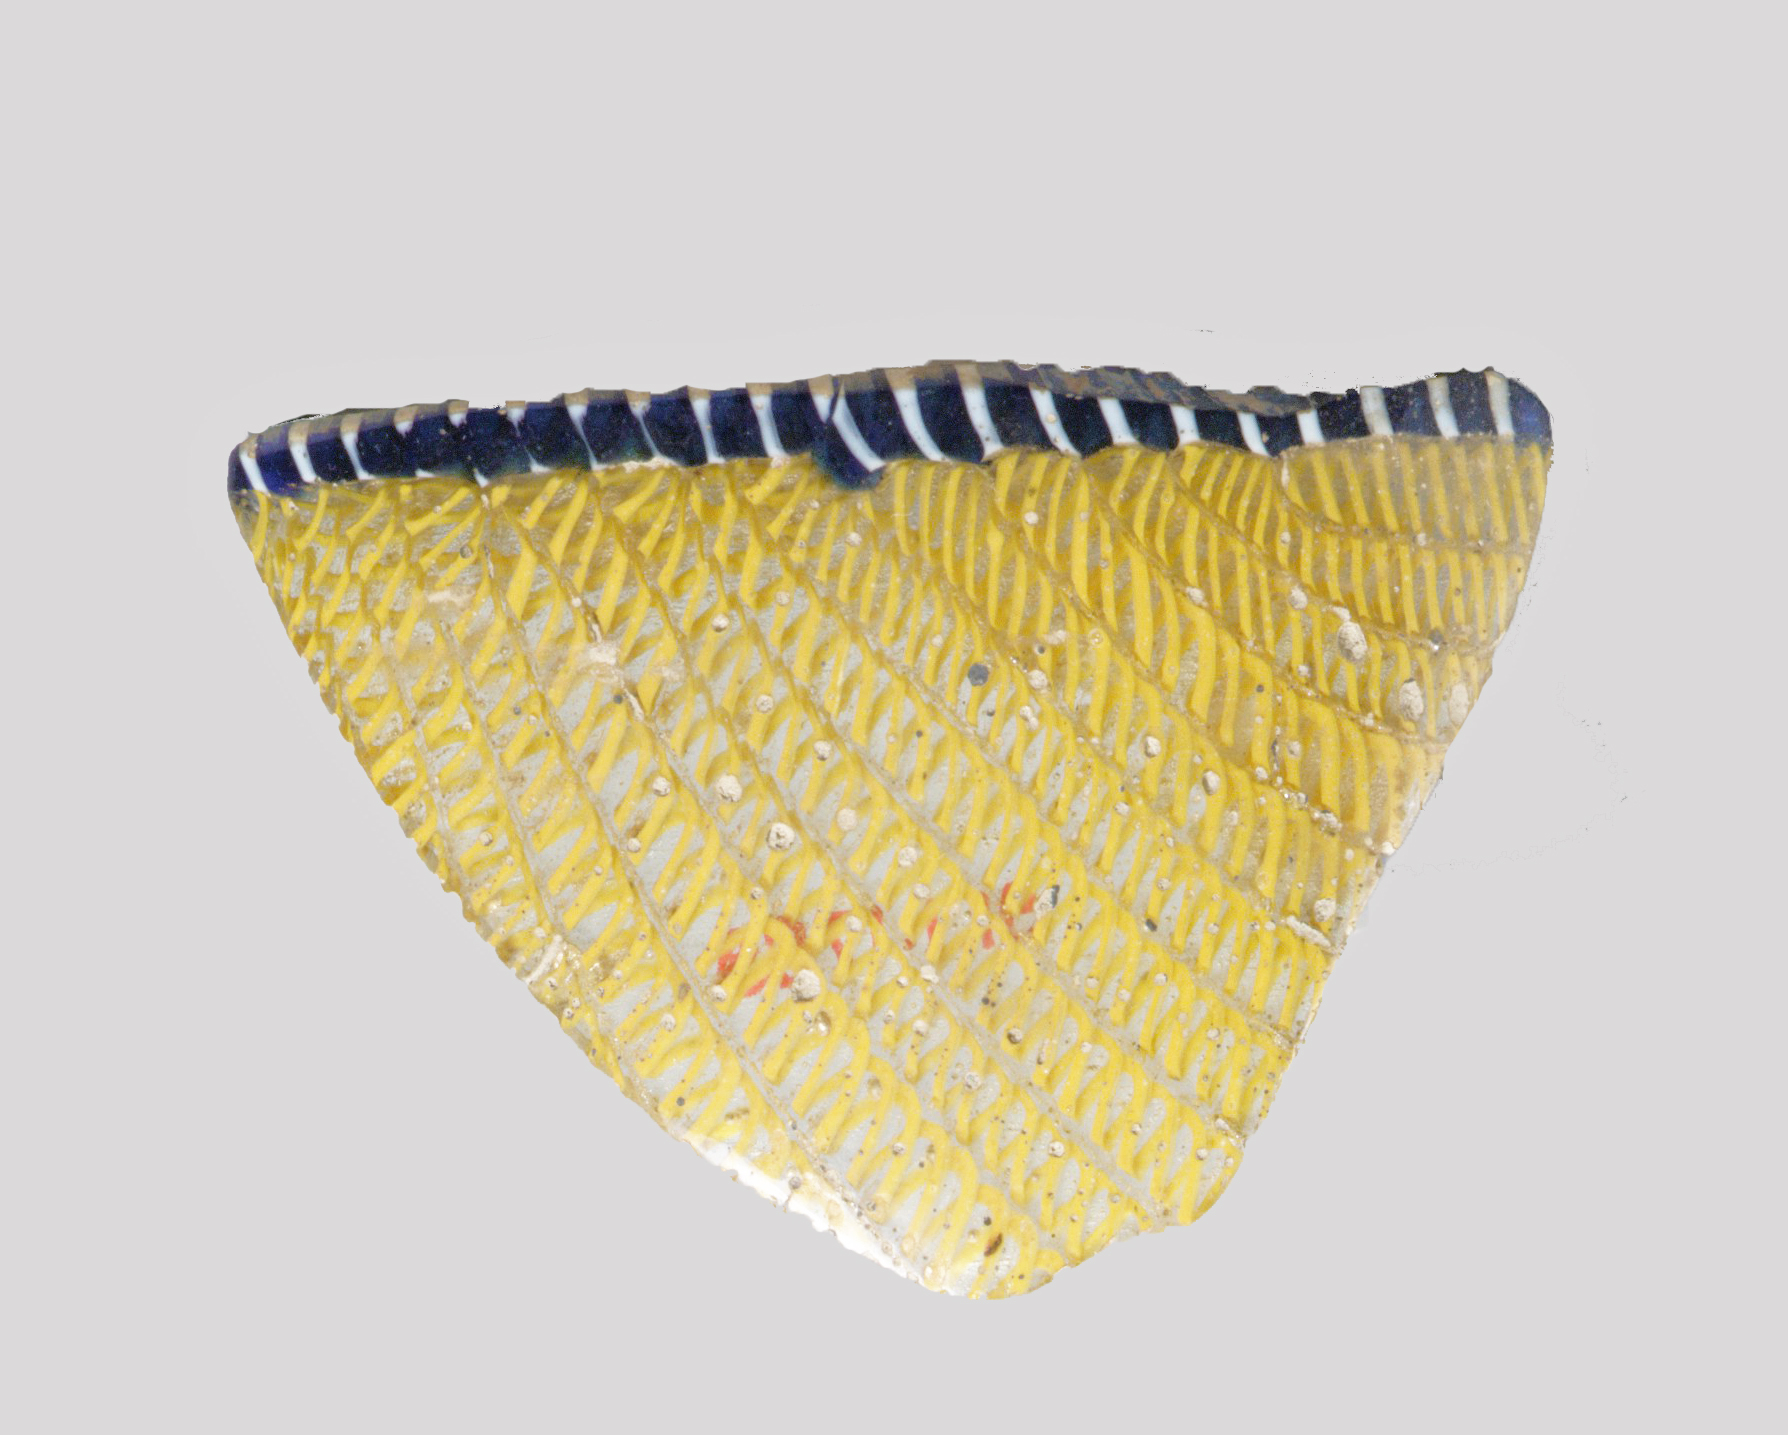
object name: fragment, network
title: Glass network mosaic bowl fragment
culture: roman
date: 34 BCE-33 CE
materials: glass